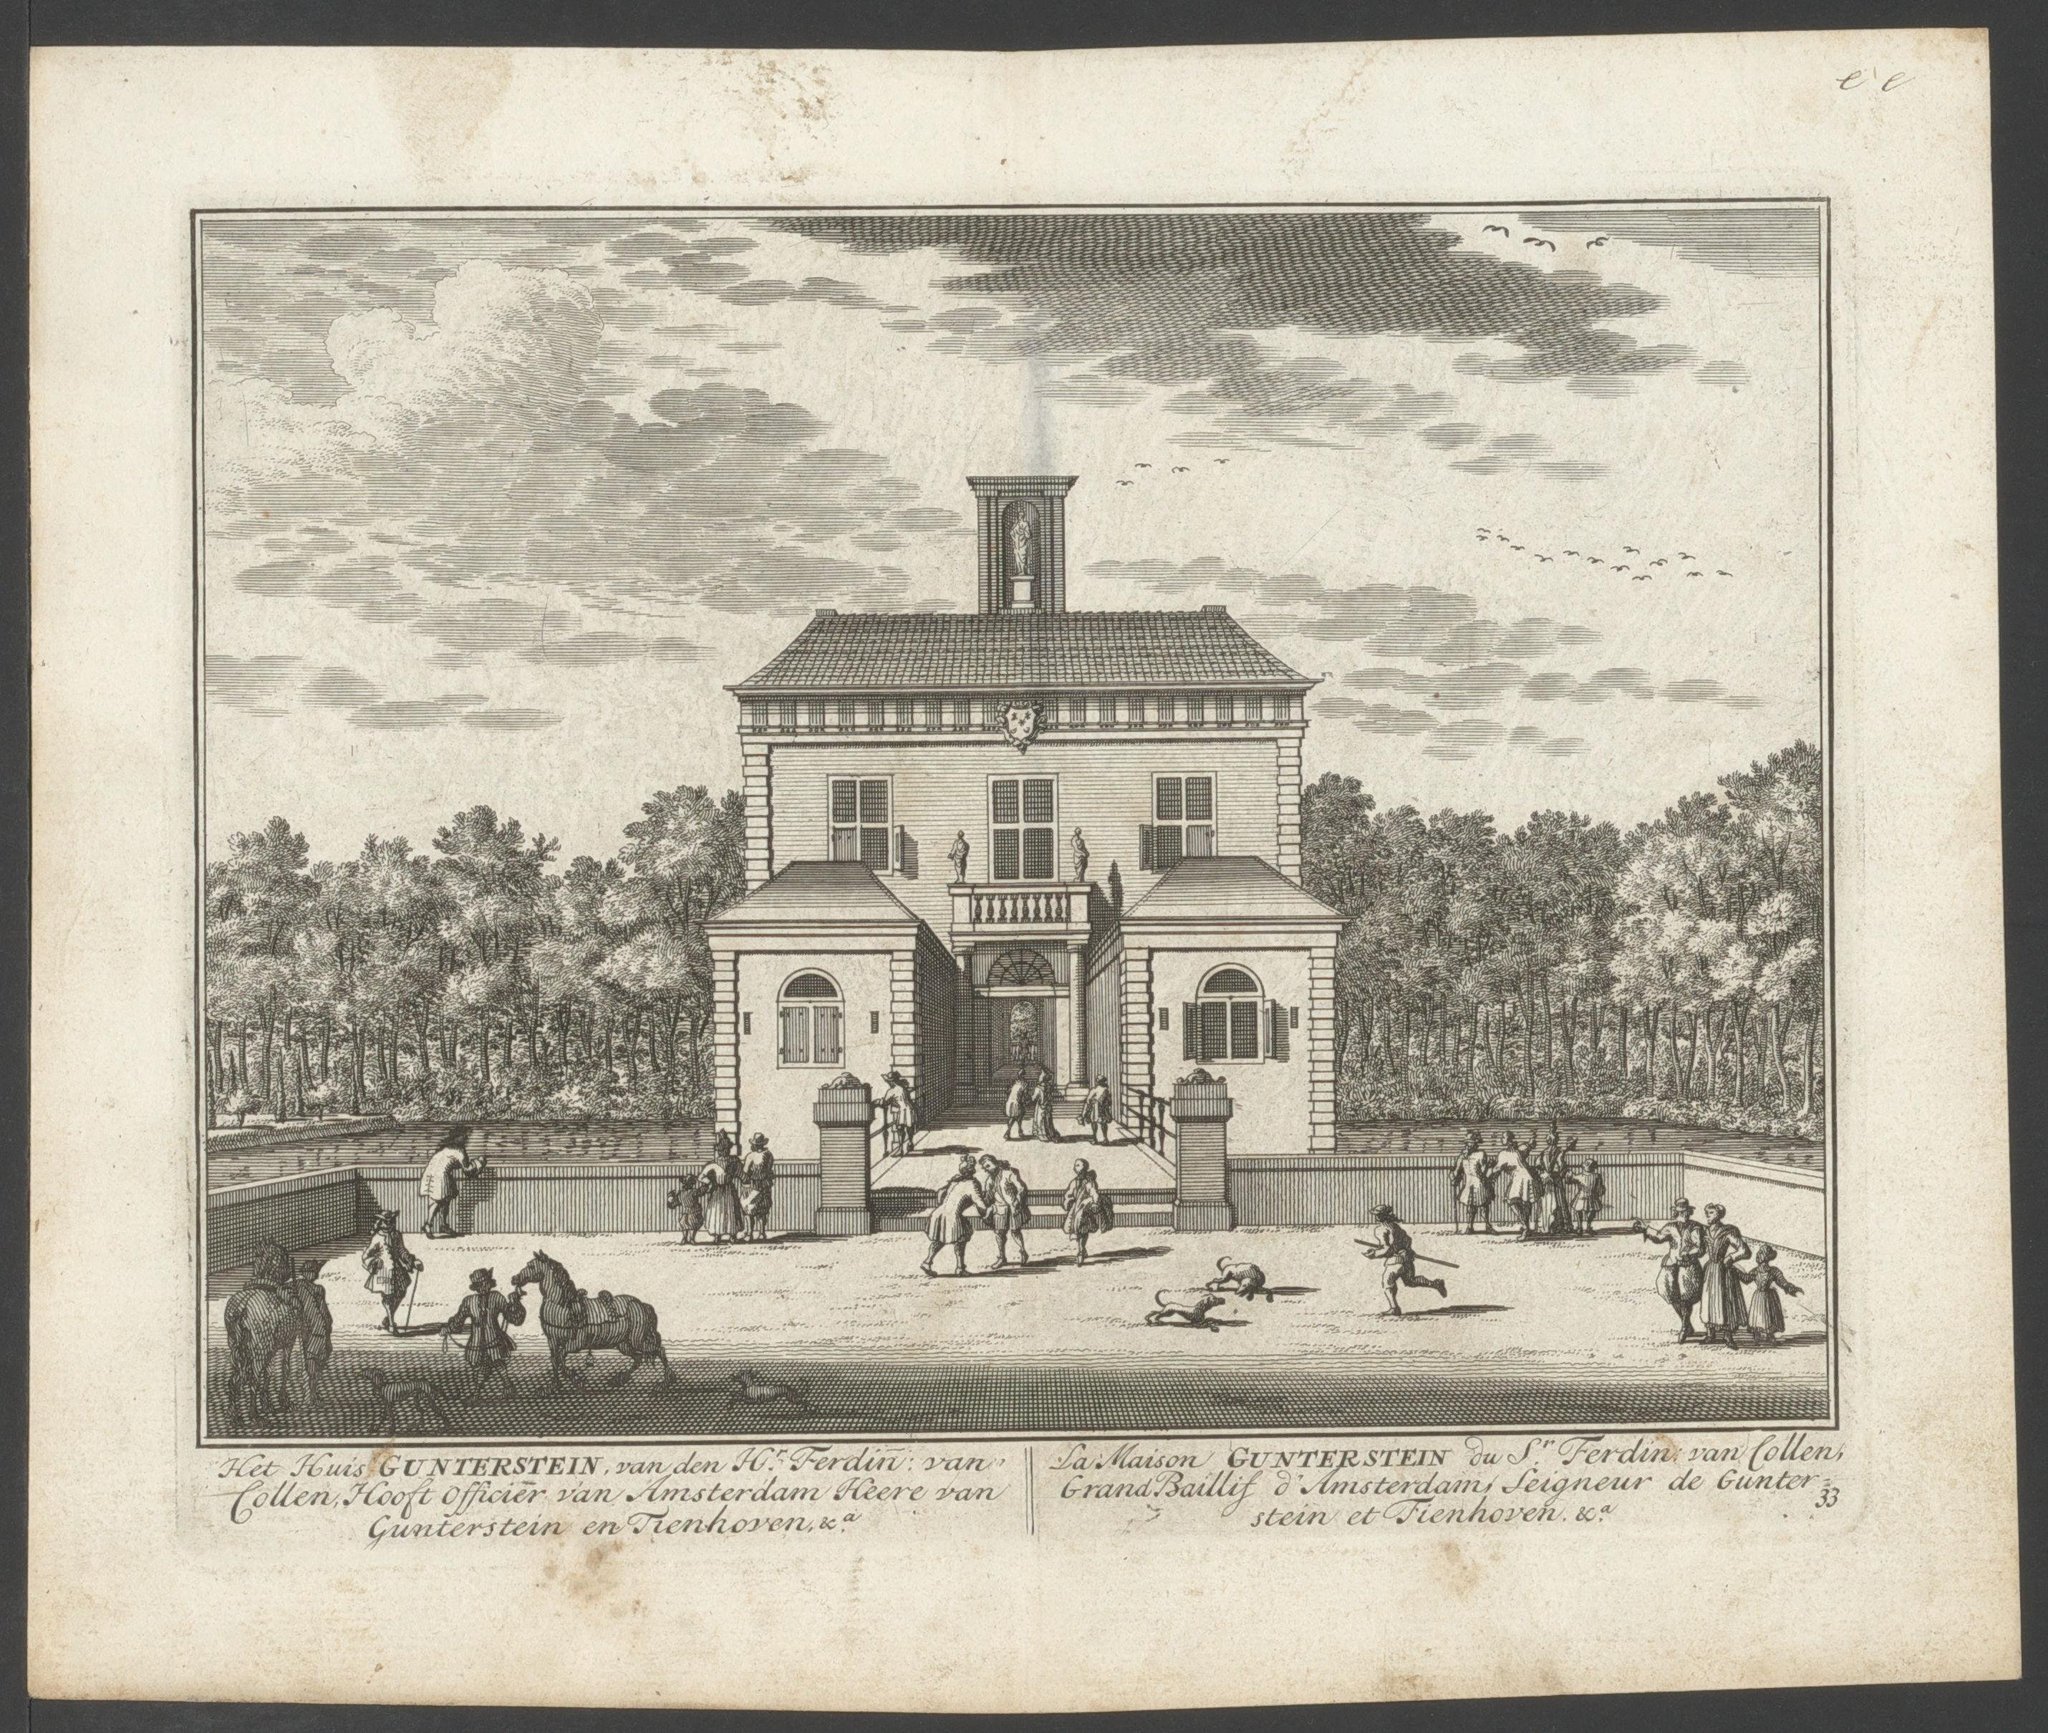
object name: print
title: Het Huis Gunterstein, van den Hr. Ferdin: van Collen, Hooft Officier van Amsterdam Heere van Gunterstein en Tienhoven, & a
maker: daniël stopendaal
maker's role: print maker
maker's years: 1672-1726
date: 1790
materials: paper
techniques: engraving, etching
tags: river (+ landscape with figures, staffage), country-house, vecht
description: Prent mogelijk uit: Leth, Andries de. De zegepraalende Vecht, vertoonende verscheidene gesichten van lustplaatsen, heeren huysen en dorpen, beginnende van Uitrecht en met Muyden besluytende (...). Amsterdam: Weduwe Nicolaus Visscher, 1719. Of uit: Brouërius van Nidek, Matthaeus. De Vechtstroom, van Utrecht tot Muiden (...). Amsterdam: H. Gartman, W. Vermandel en J.W. Smit, 1790.